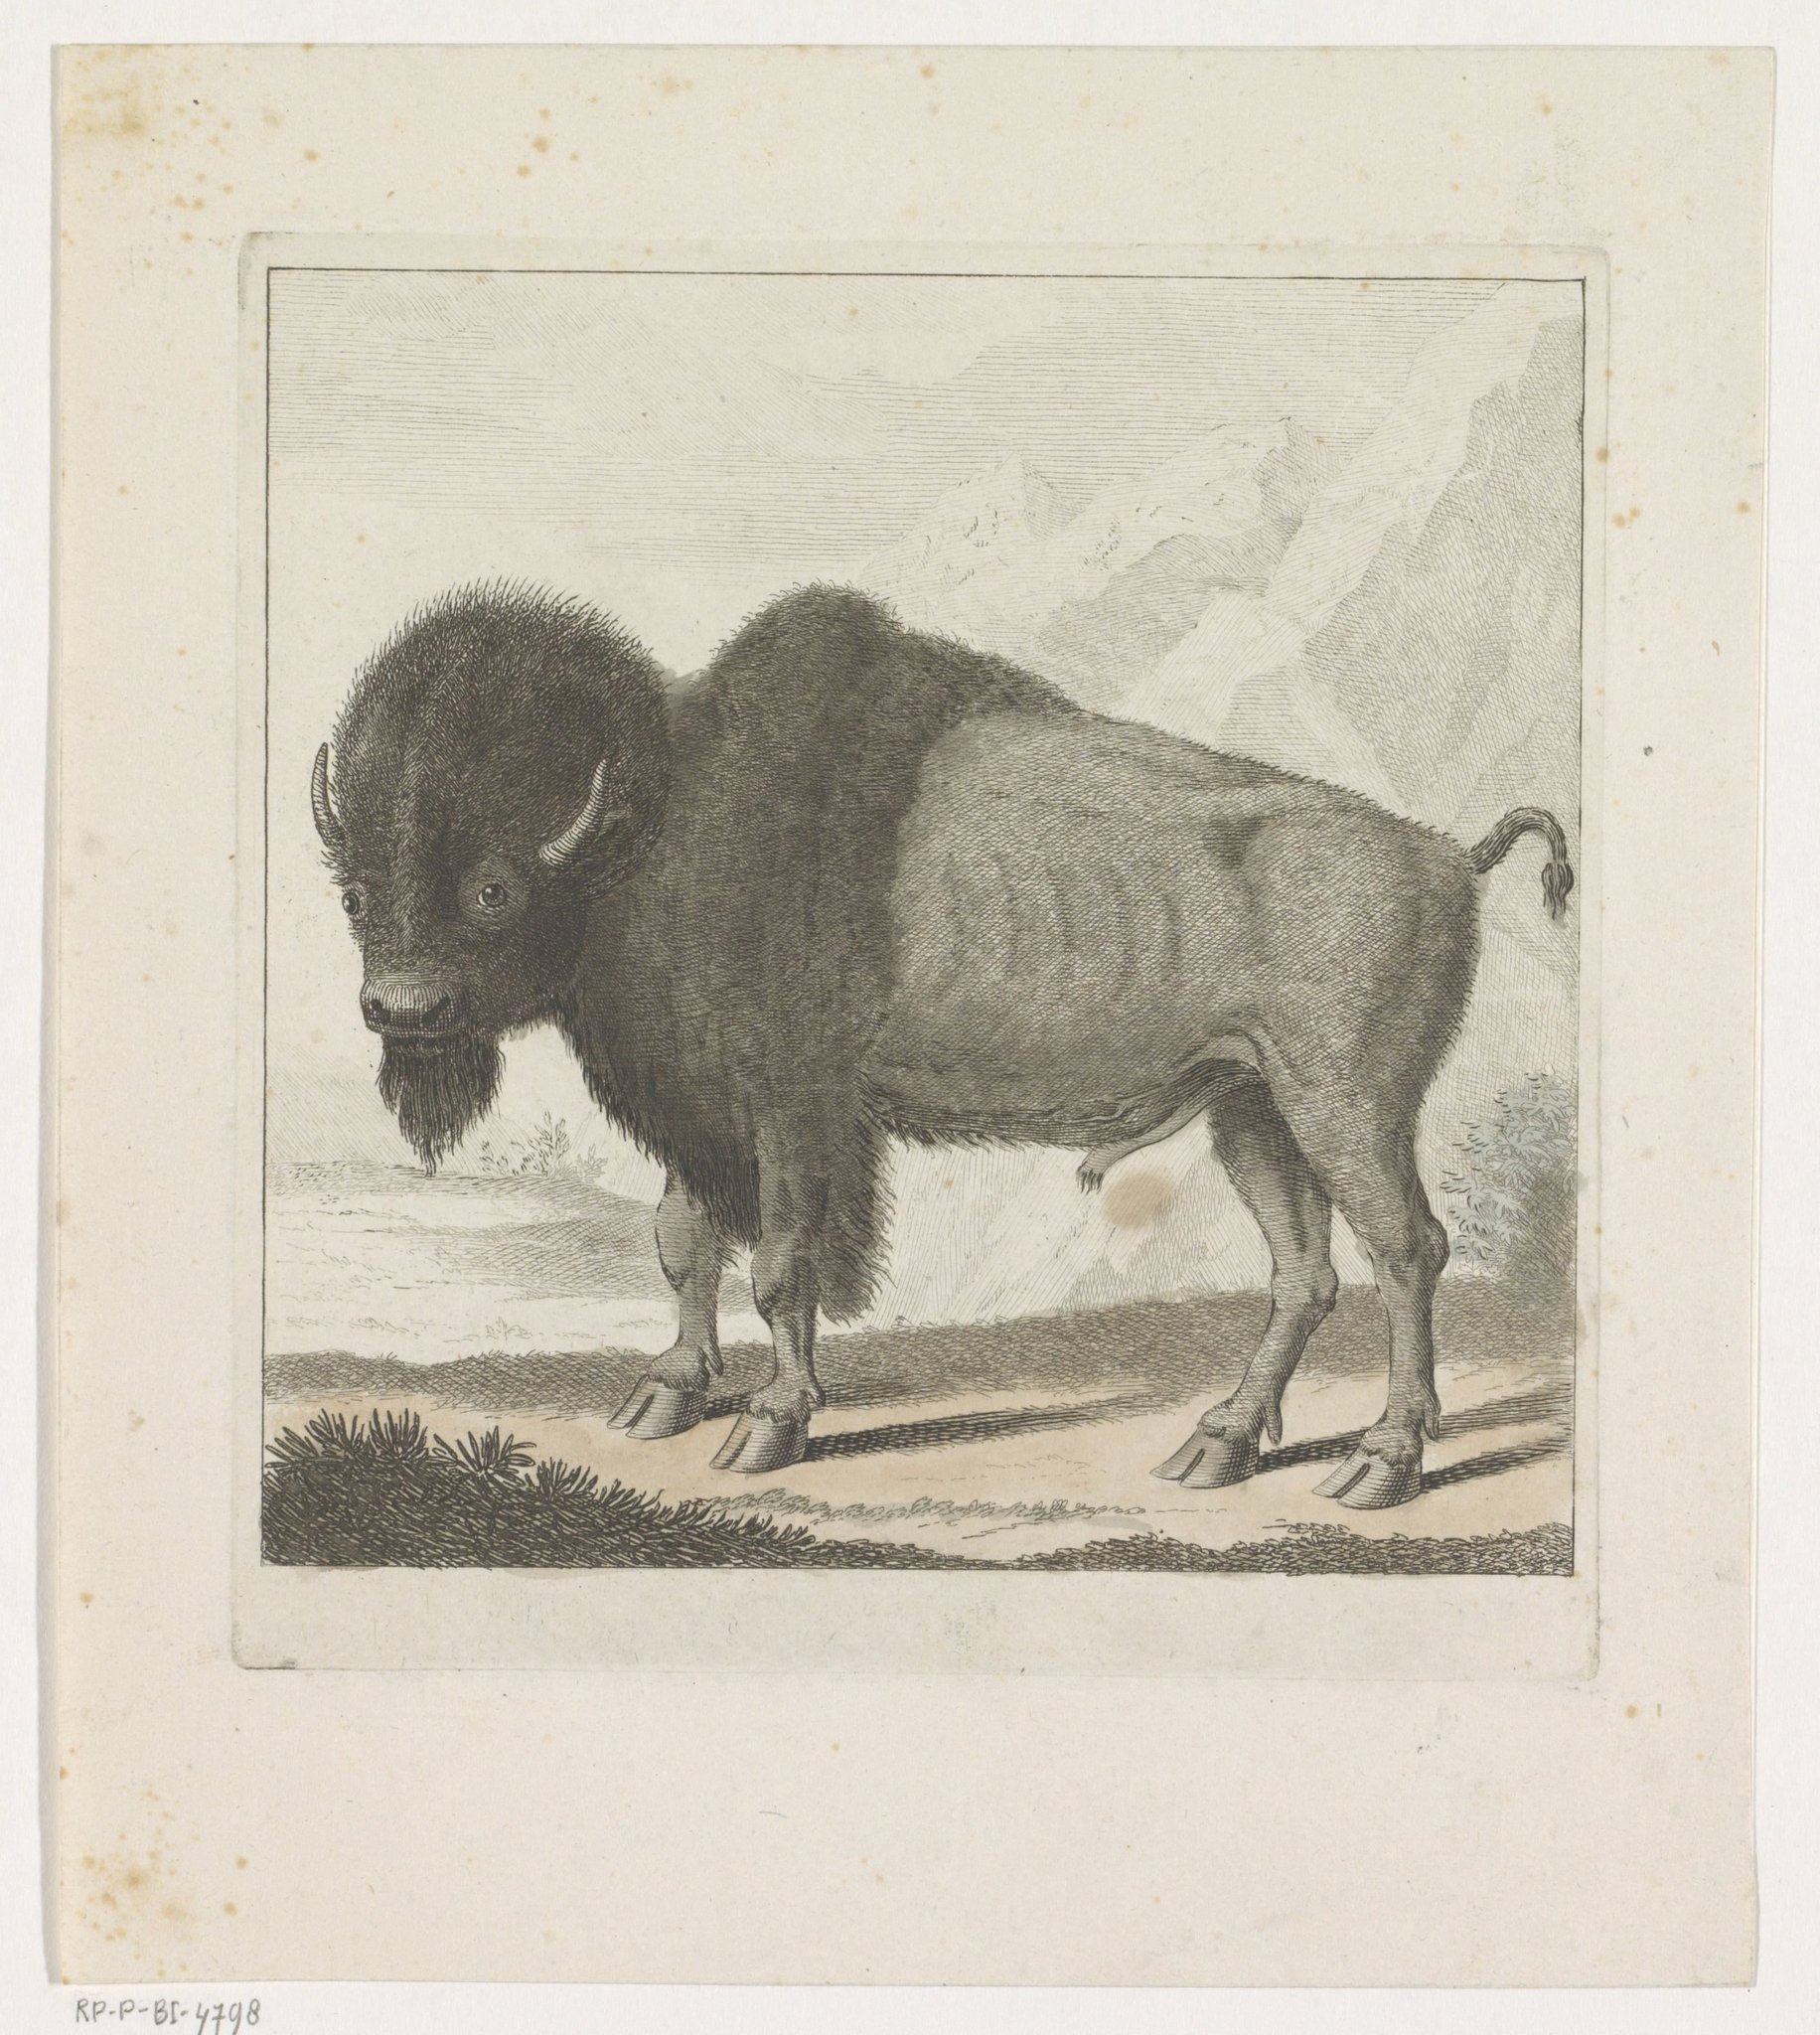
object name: print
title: Bizon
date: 1735-1859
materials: paper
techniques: etching, hand coloring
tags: hoofed animals: bison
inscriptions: collector's mark: Lugt 240